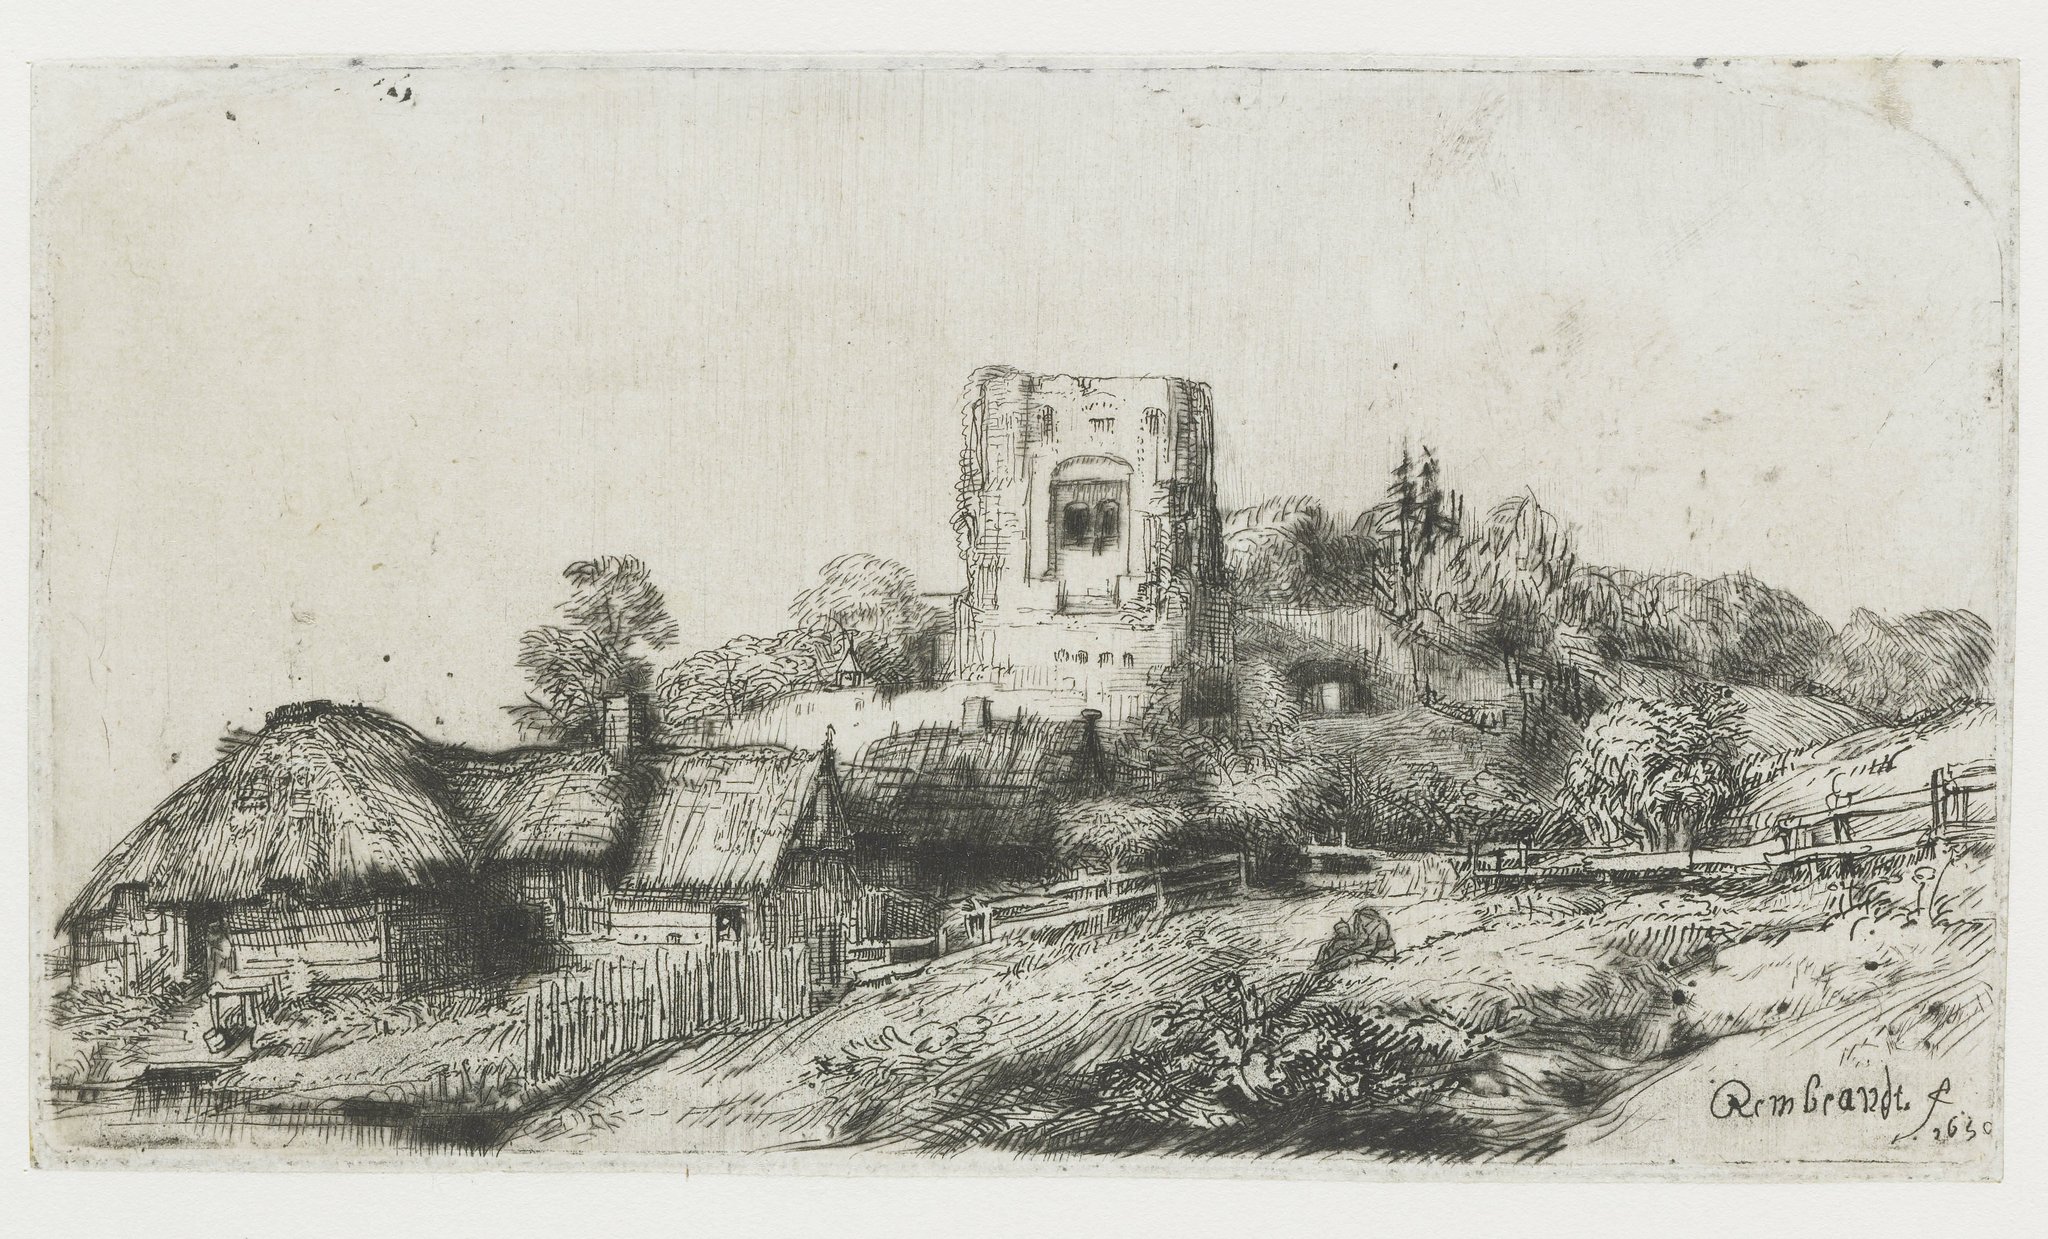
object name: print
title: Landscape with a square tower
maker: rembrandt van rijn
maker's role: draughtsman, painter, print maker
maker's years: 1606-1669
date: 1650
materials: paper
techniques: drypoint, etching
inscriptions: signature and date: ‘Rembrandt f 1650’, collector's mark: Lugt 2228, inscription: ‘C. 8932’